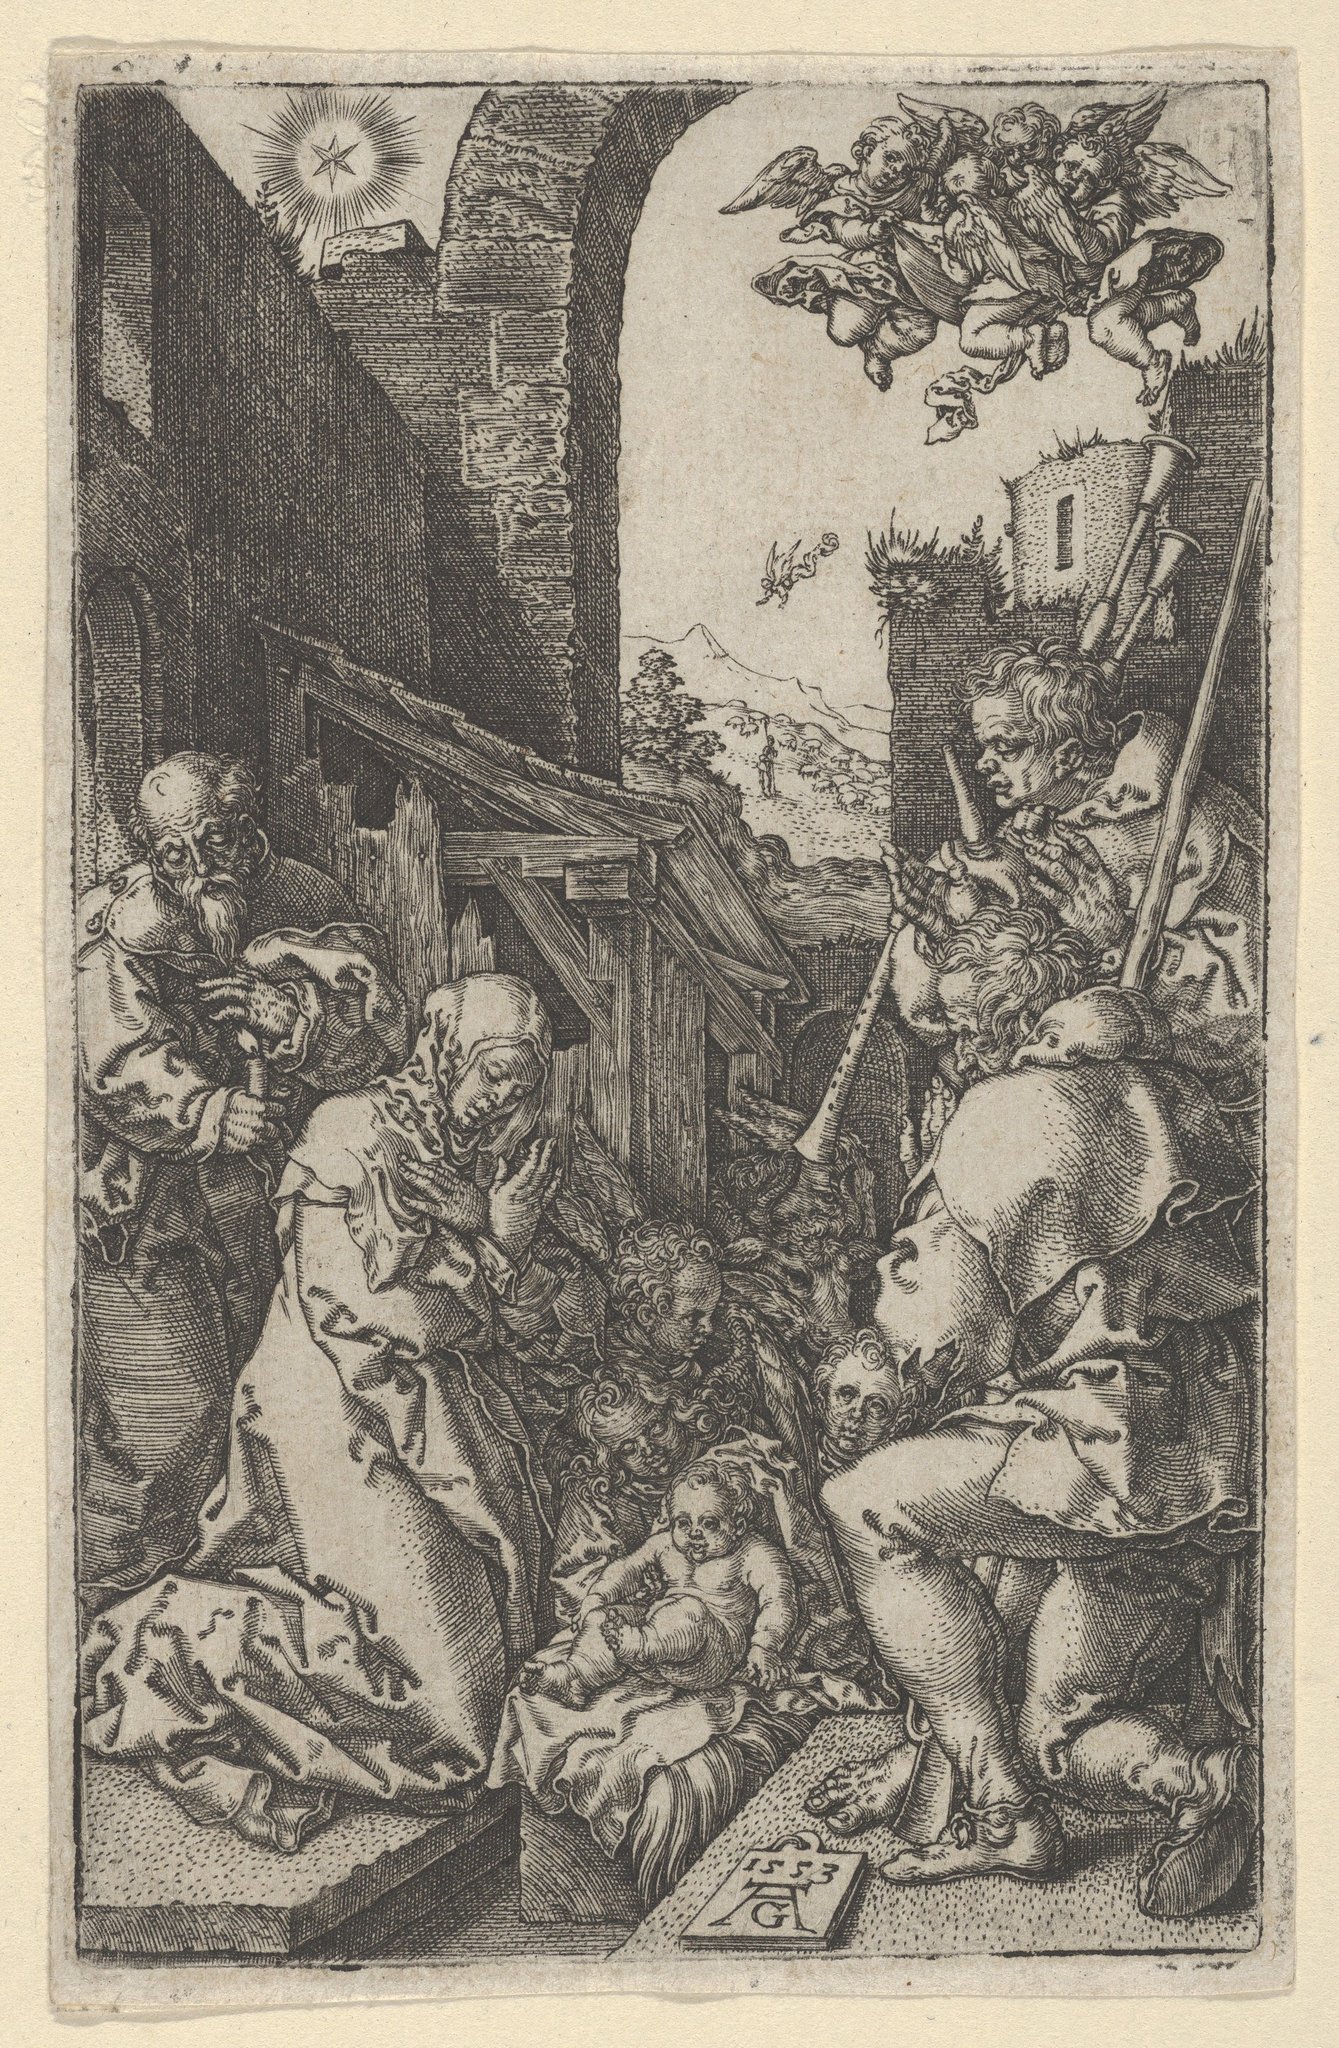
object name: print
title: The Adoration of the Shepherds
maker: heinrich aldegrever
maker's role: artist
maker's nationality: german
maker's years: 1502-1561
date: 1553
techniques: engraving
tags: angels,christ,virgin mary,adoration of the shepherds